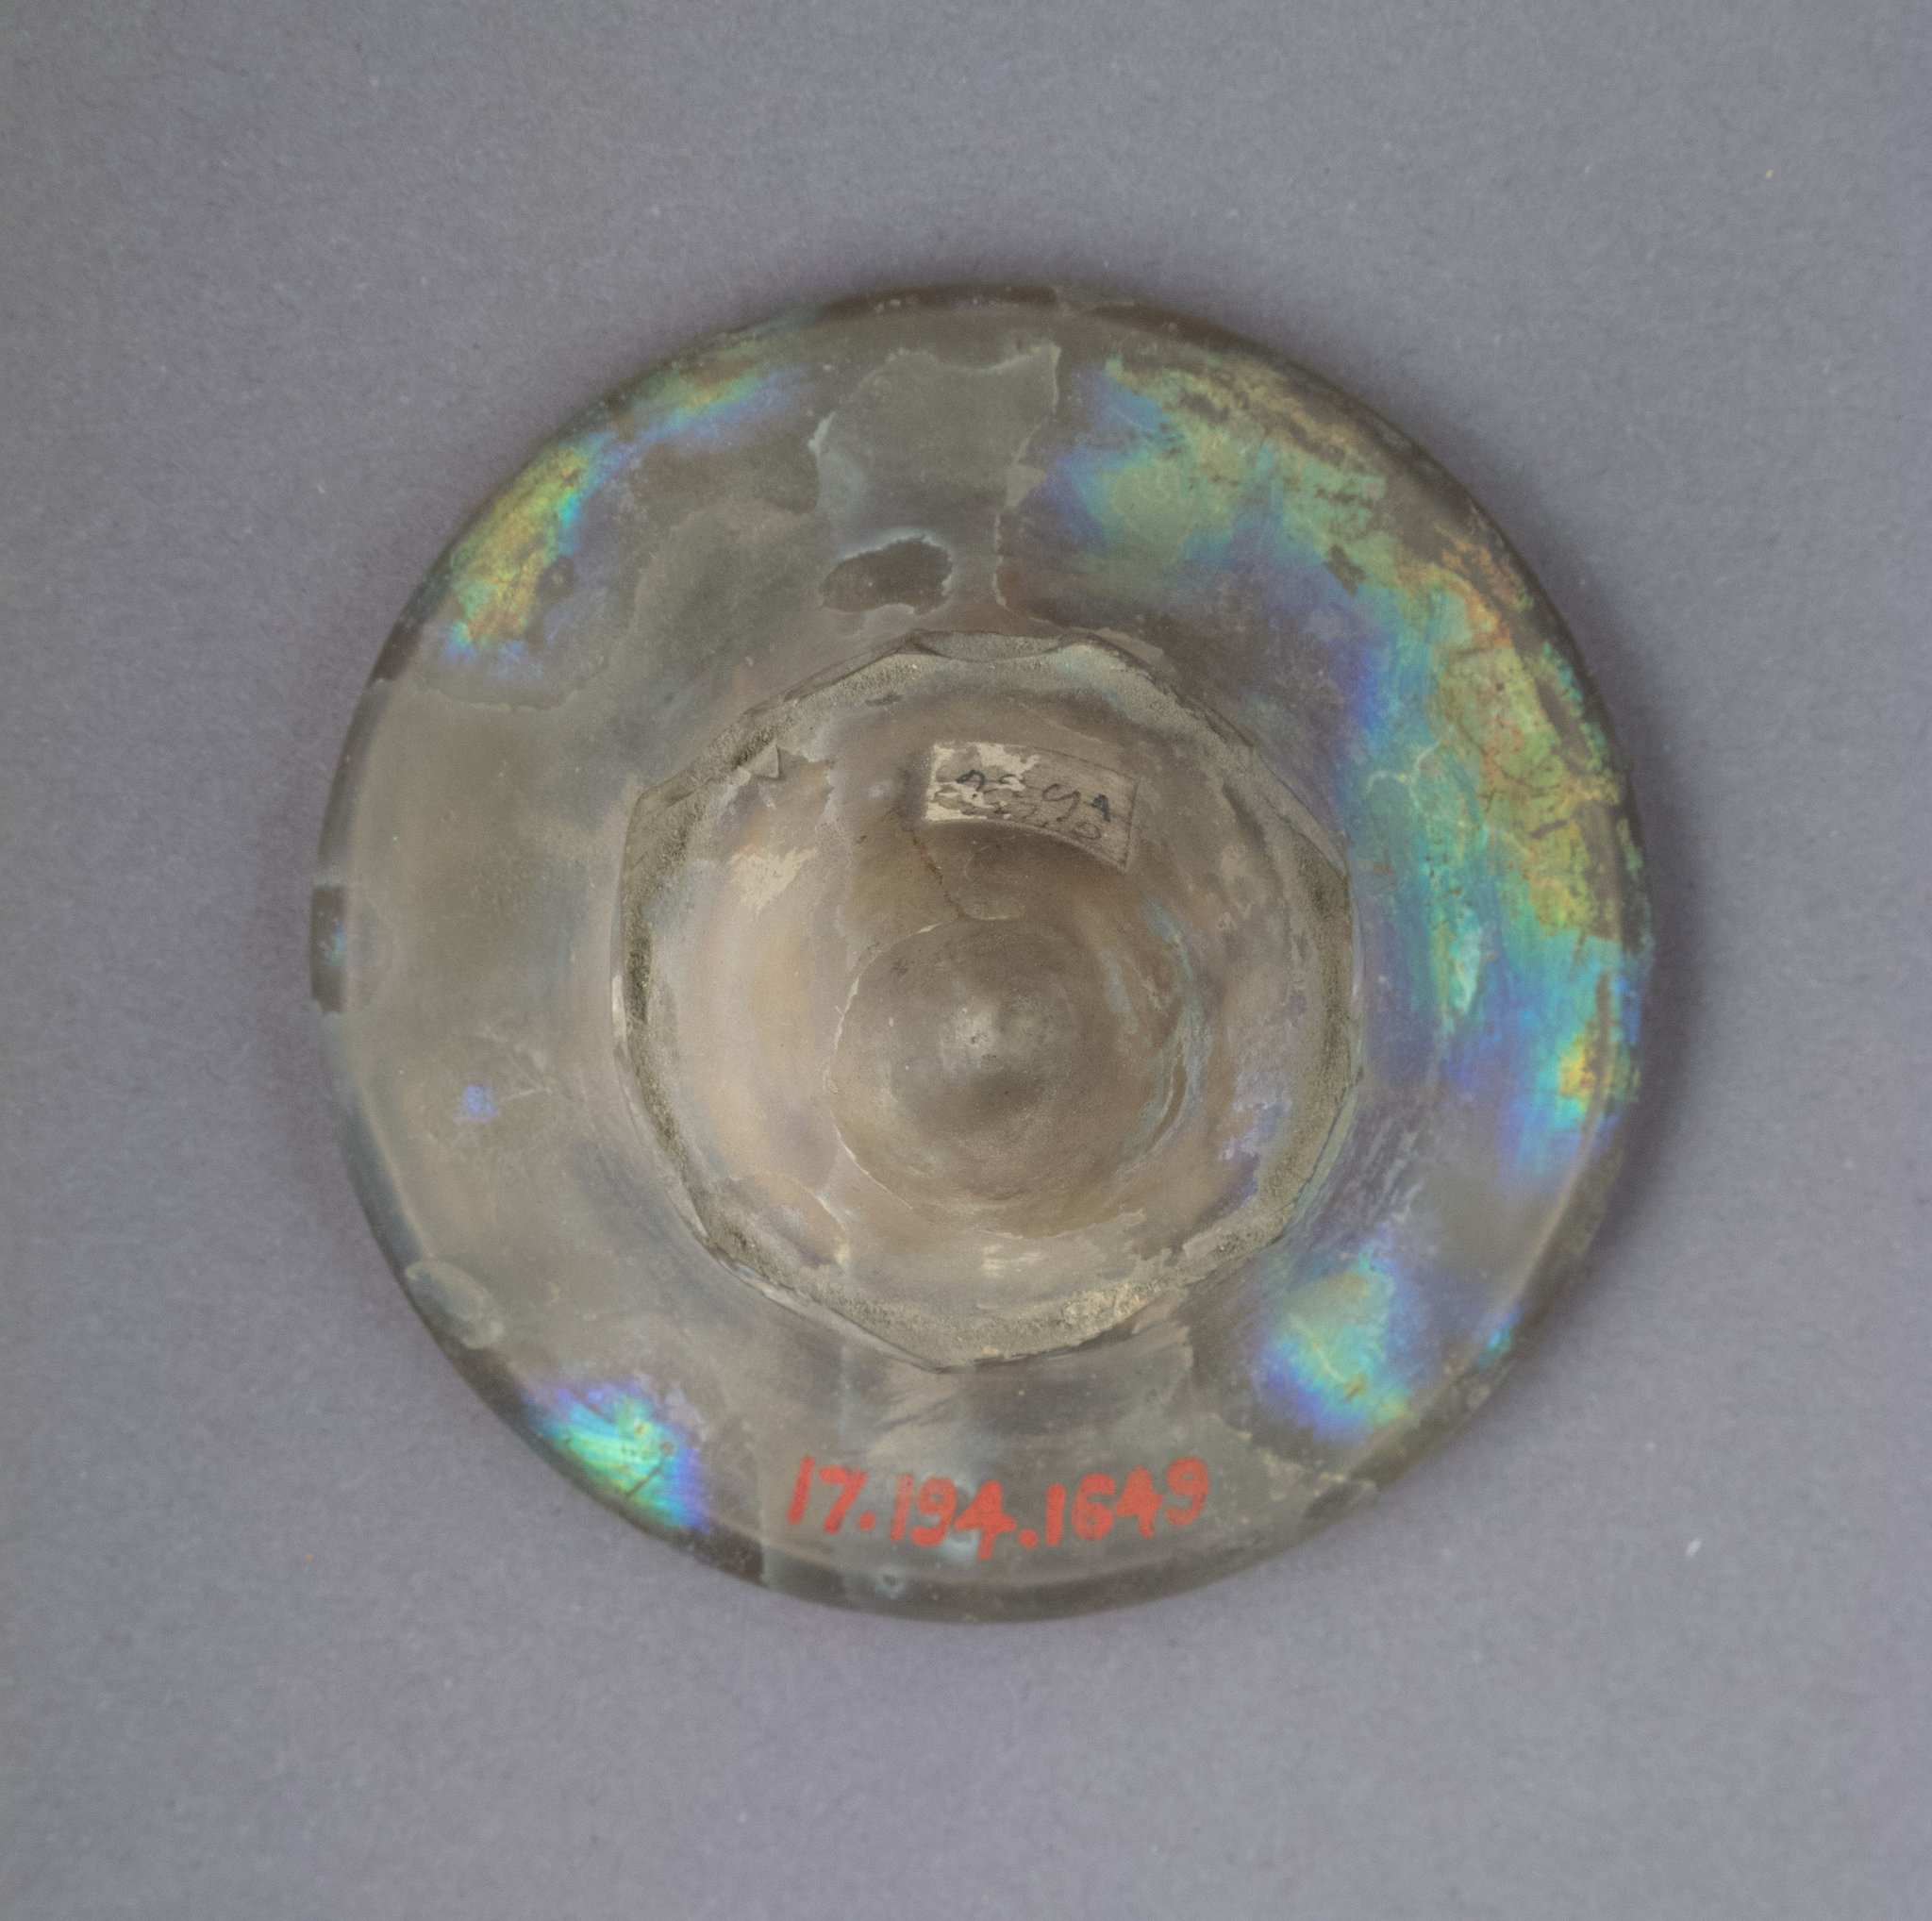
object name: fragment of a base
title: Glass base fragment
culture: roman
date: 301-400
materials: glass